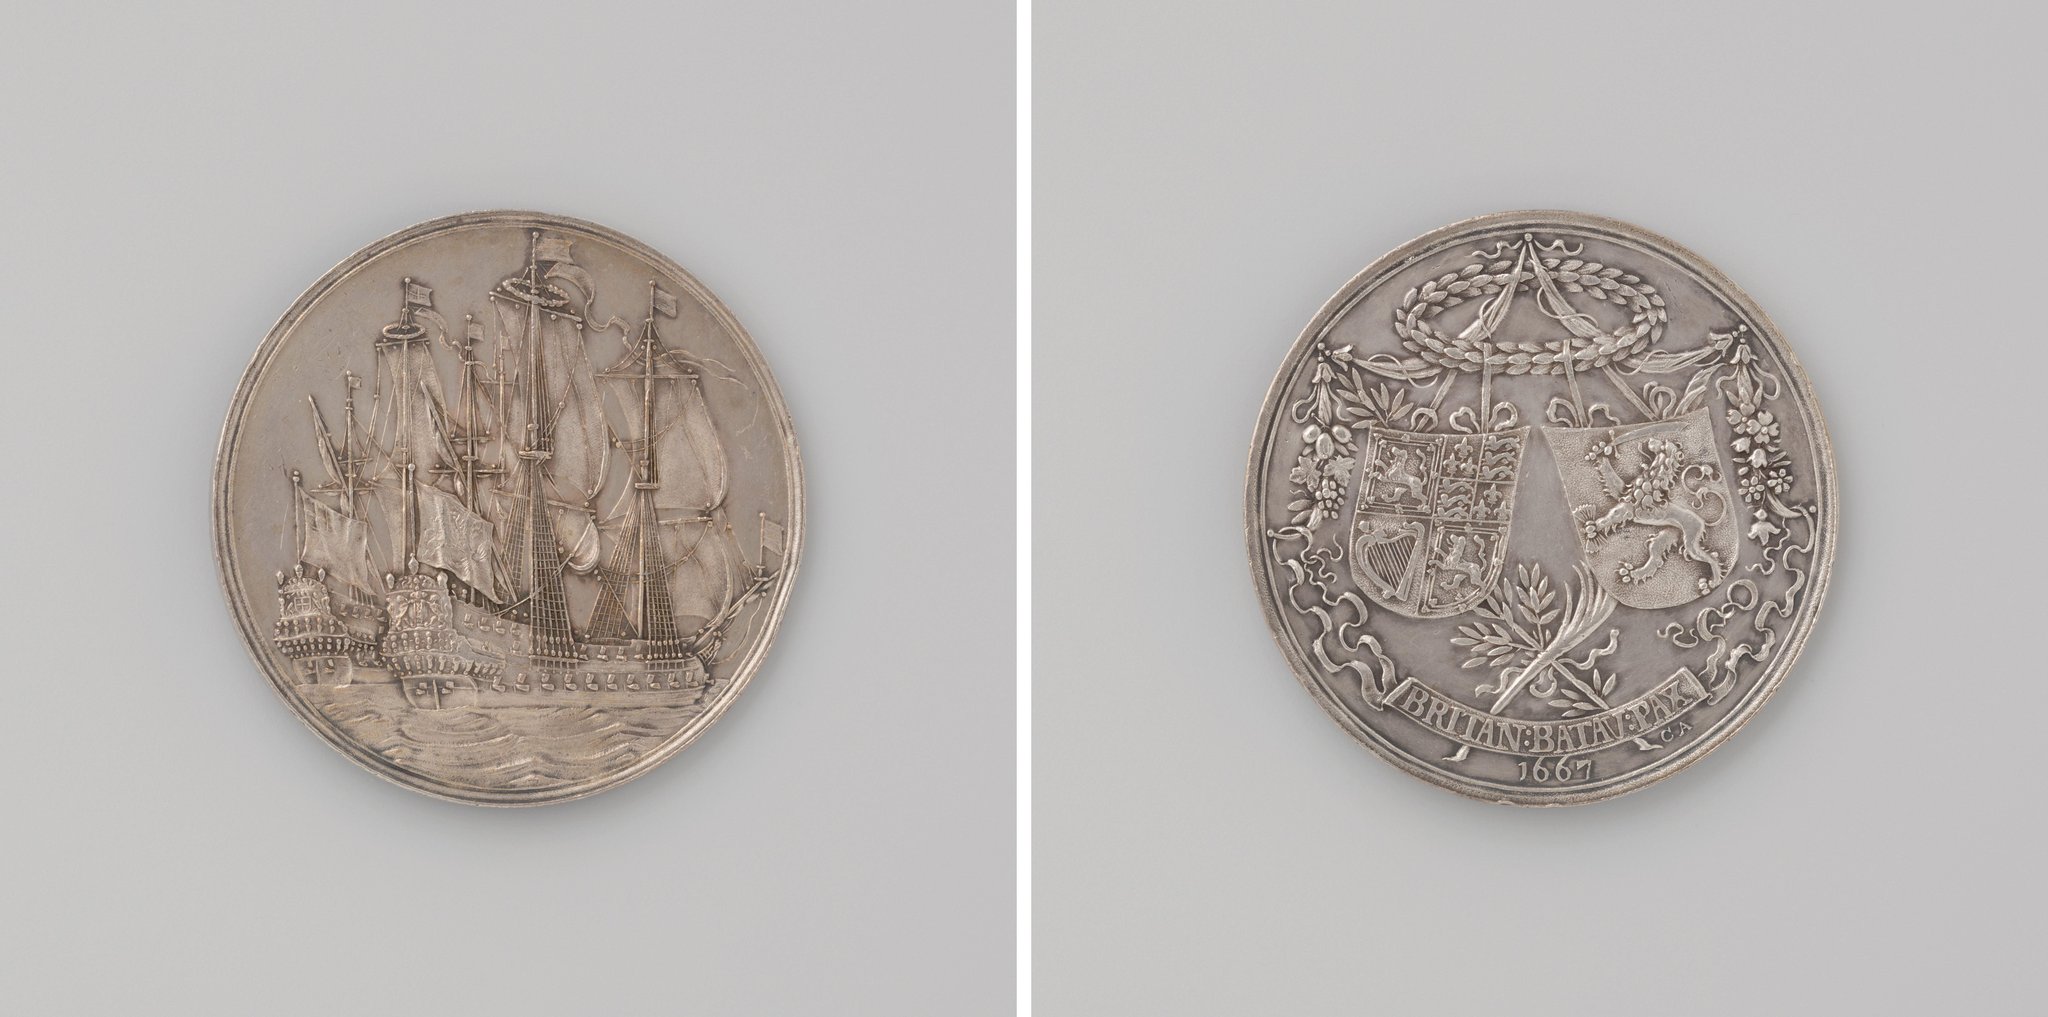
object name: history medal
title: Vrede van Breda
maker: christoffel adolphi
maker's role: medailleur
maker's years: 1630-1684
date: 1667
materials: silver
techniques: striking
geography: amsterdam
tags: breda, vrede van breda (1667)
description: Zilveren penning. Voorzijde: Nederlands en Brits admiraalsschip. Keerzijde: twee gekroonde wapenschild, samengebonden onder krans, met gekruiste palm- en olijftak boven wimpel met opschrift